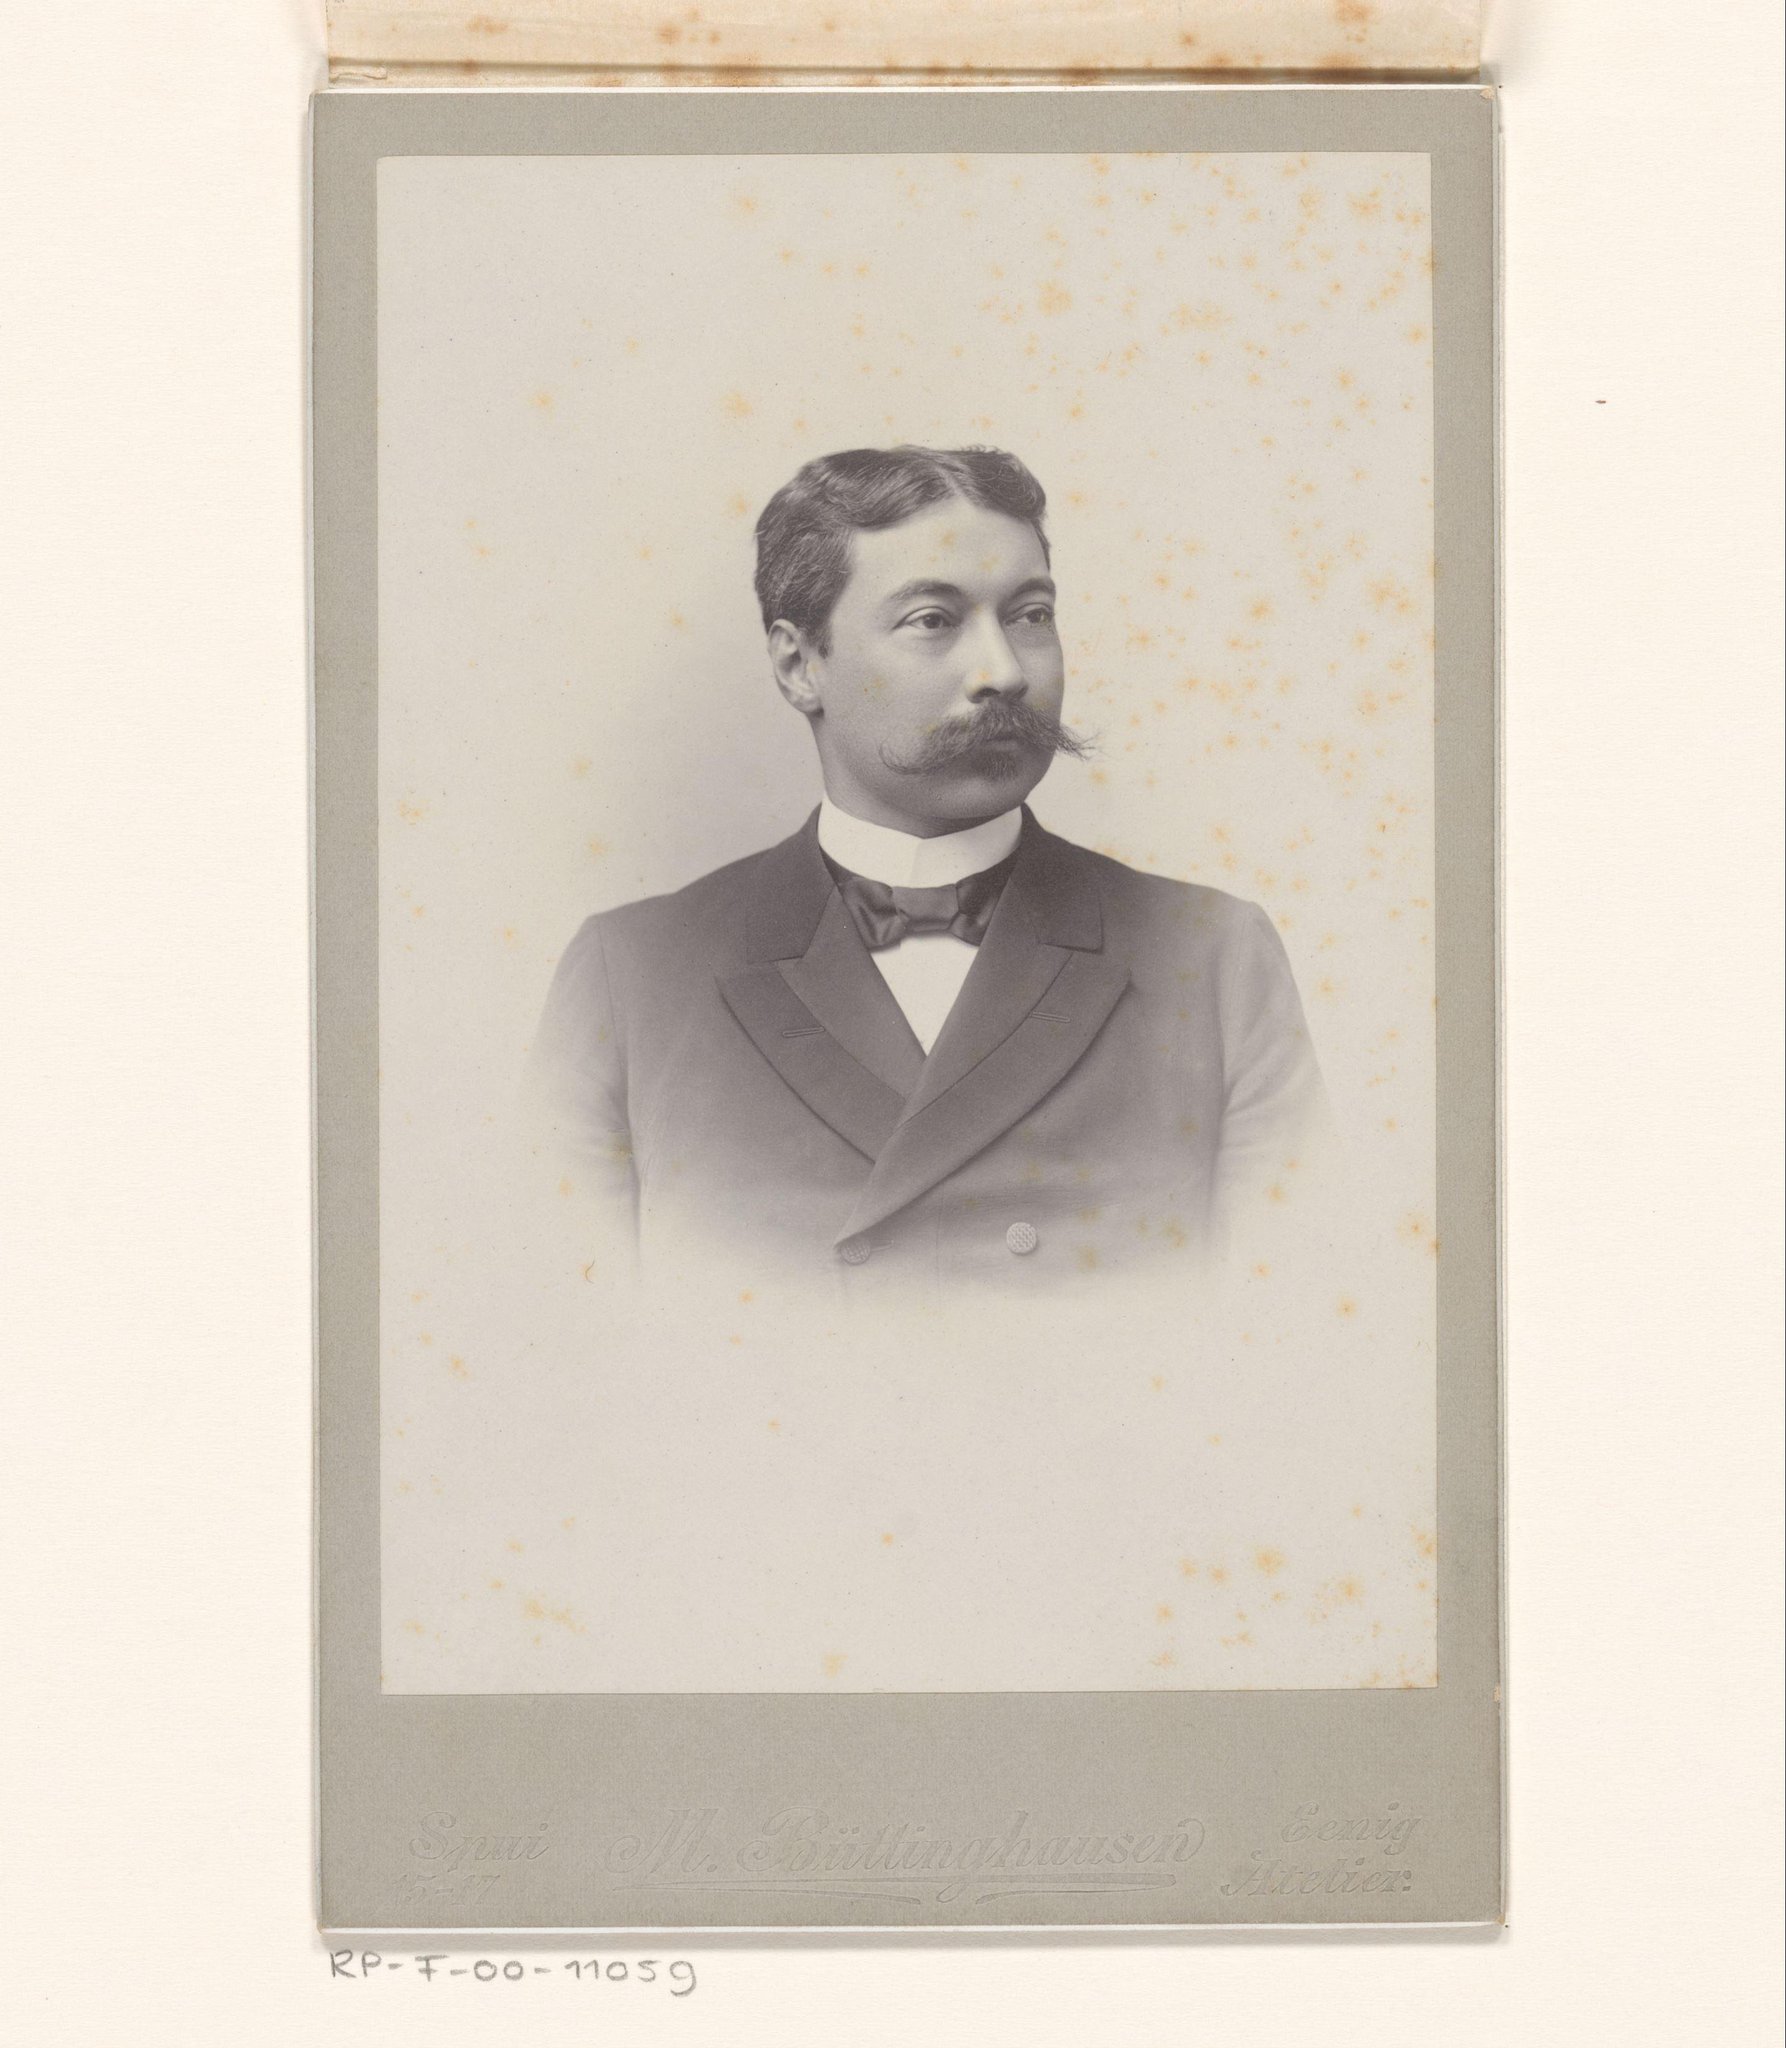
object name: cabinet photograph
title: Portret van een onbekende man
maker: max büttinghausen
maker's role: fotograaf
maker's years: 1847-1906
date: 1886-1906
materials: cardboard, photographic support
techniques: matte daylight collodion silver print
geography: amsterdam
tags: historical persons not known by name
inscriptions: collector's mark: Lugt 2228a, inscription: ‘Spui/ 15-17/ M. Büttinghausen/ Eenig/ Atelier’